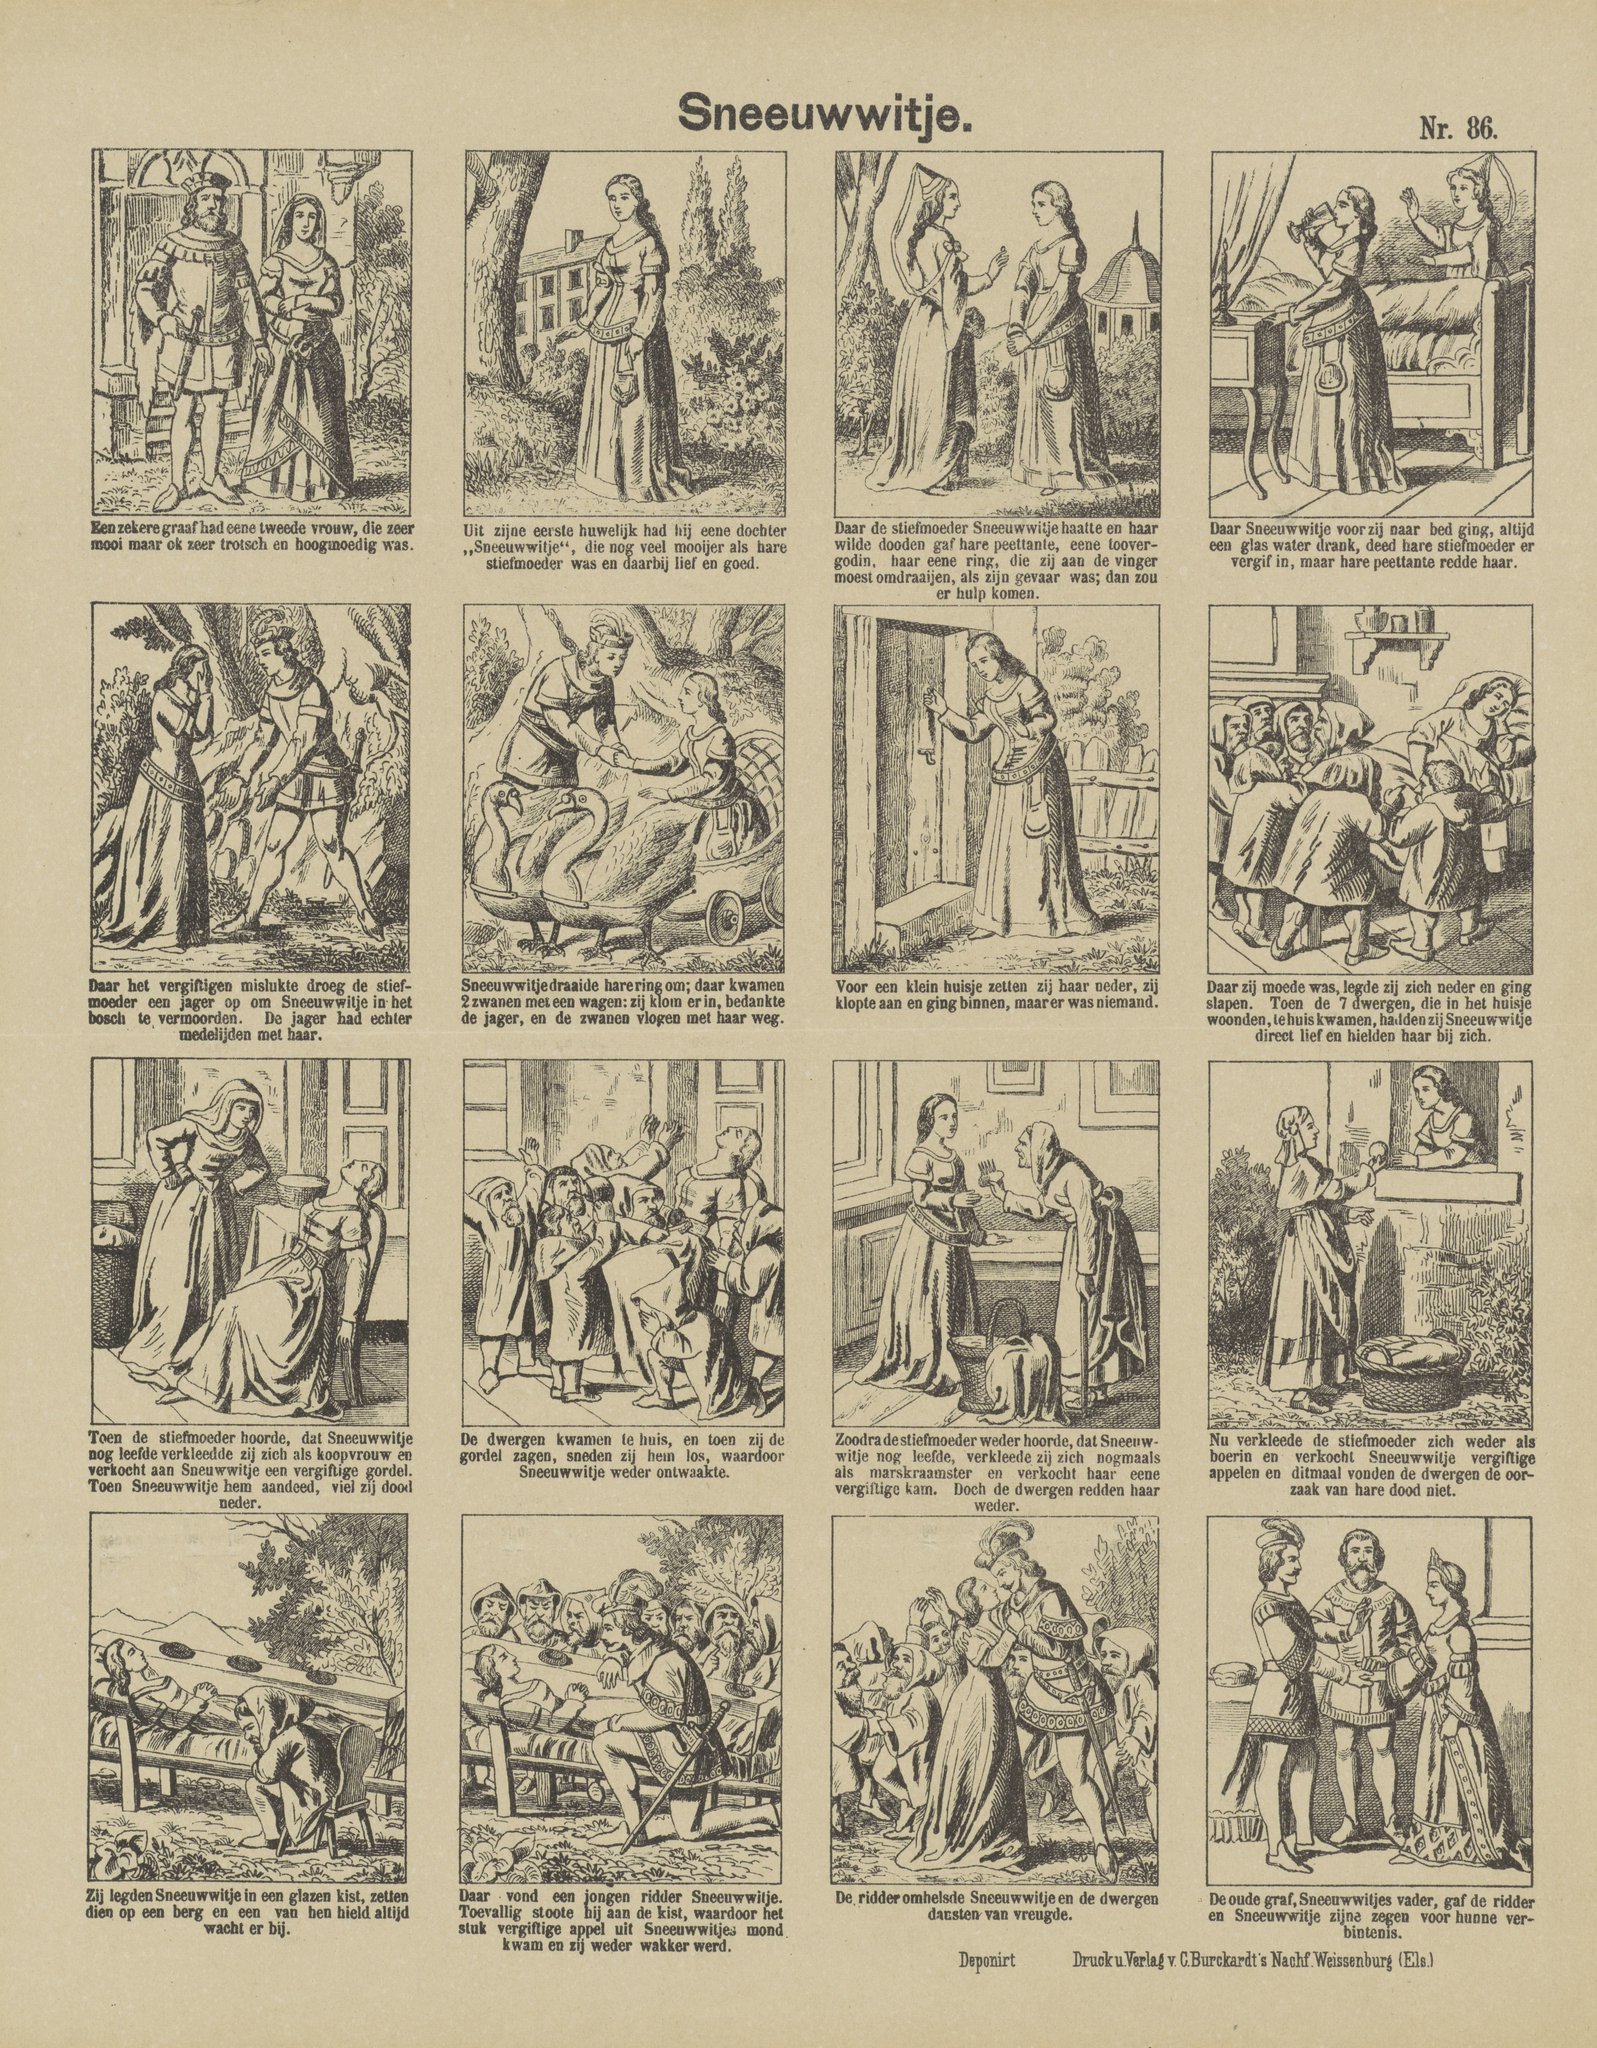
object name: print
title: Sneeuwwitje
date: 1889-1906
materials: paper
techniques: letterpress printing, lithograph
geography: wissembourg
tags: princess, tales and fairy tales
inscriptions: collector's mark: Lugt 2760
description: Blad met 16 voorstellingen uit het sprookje van Sneeuwwitje. Onder elke afbeelding een onderschrift. Genummerd rechtsboven: No. 86.